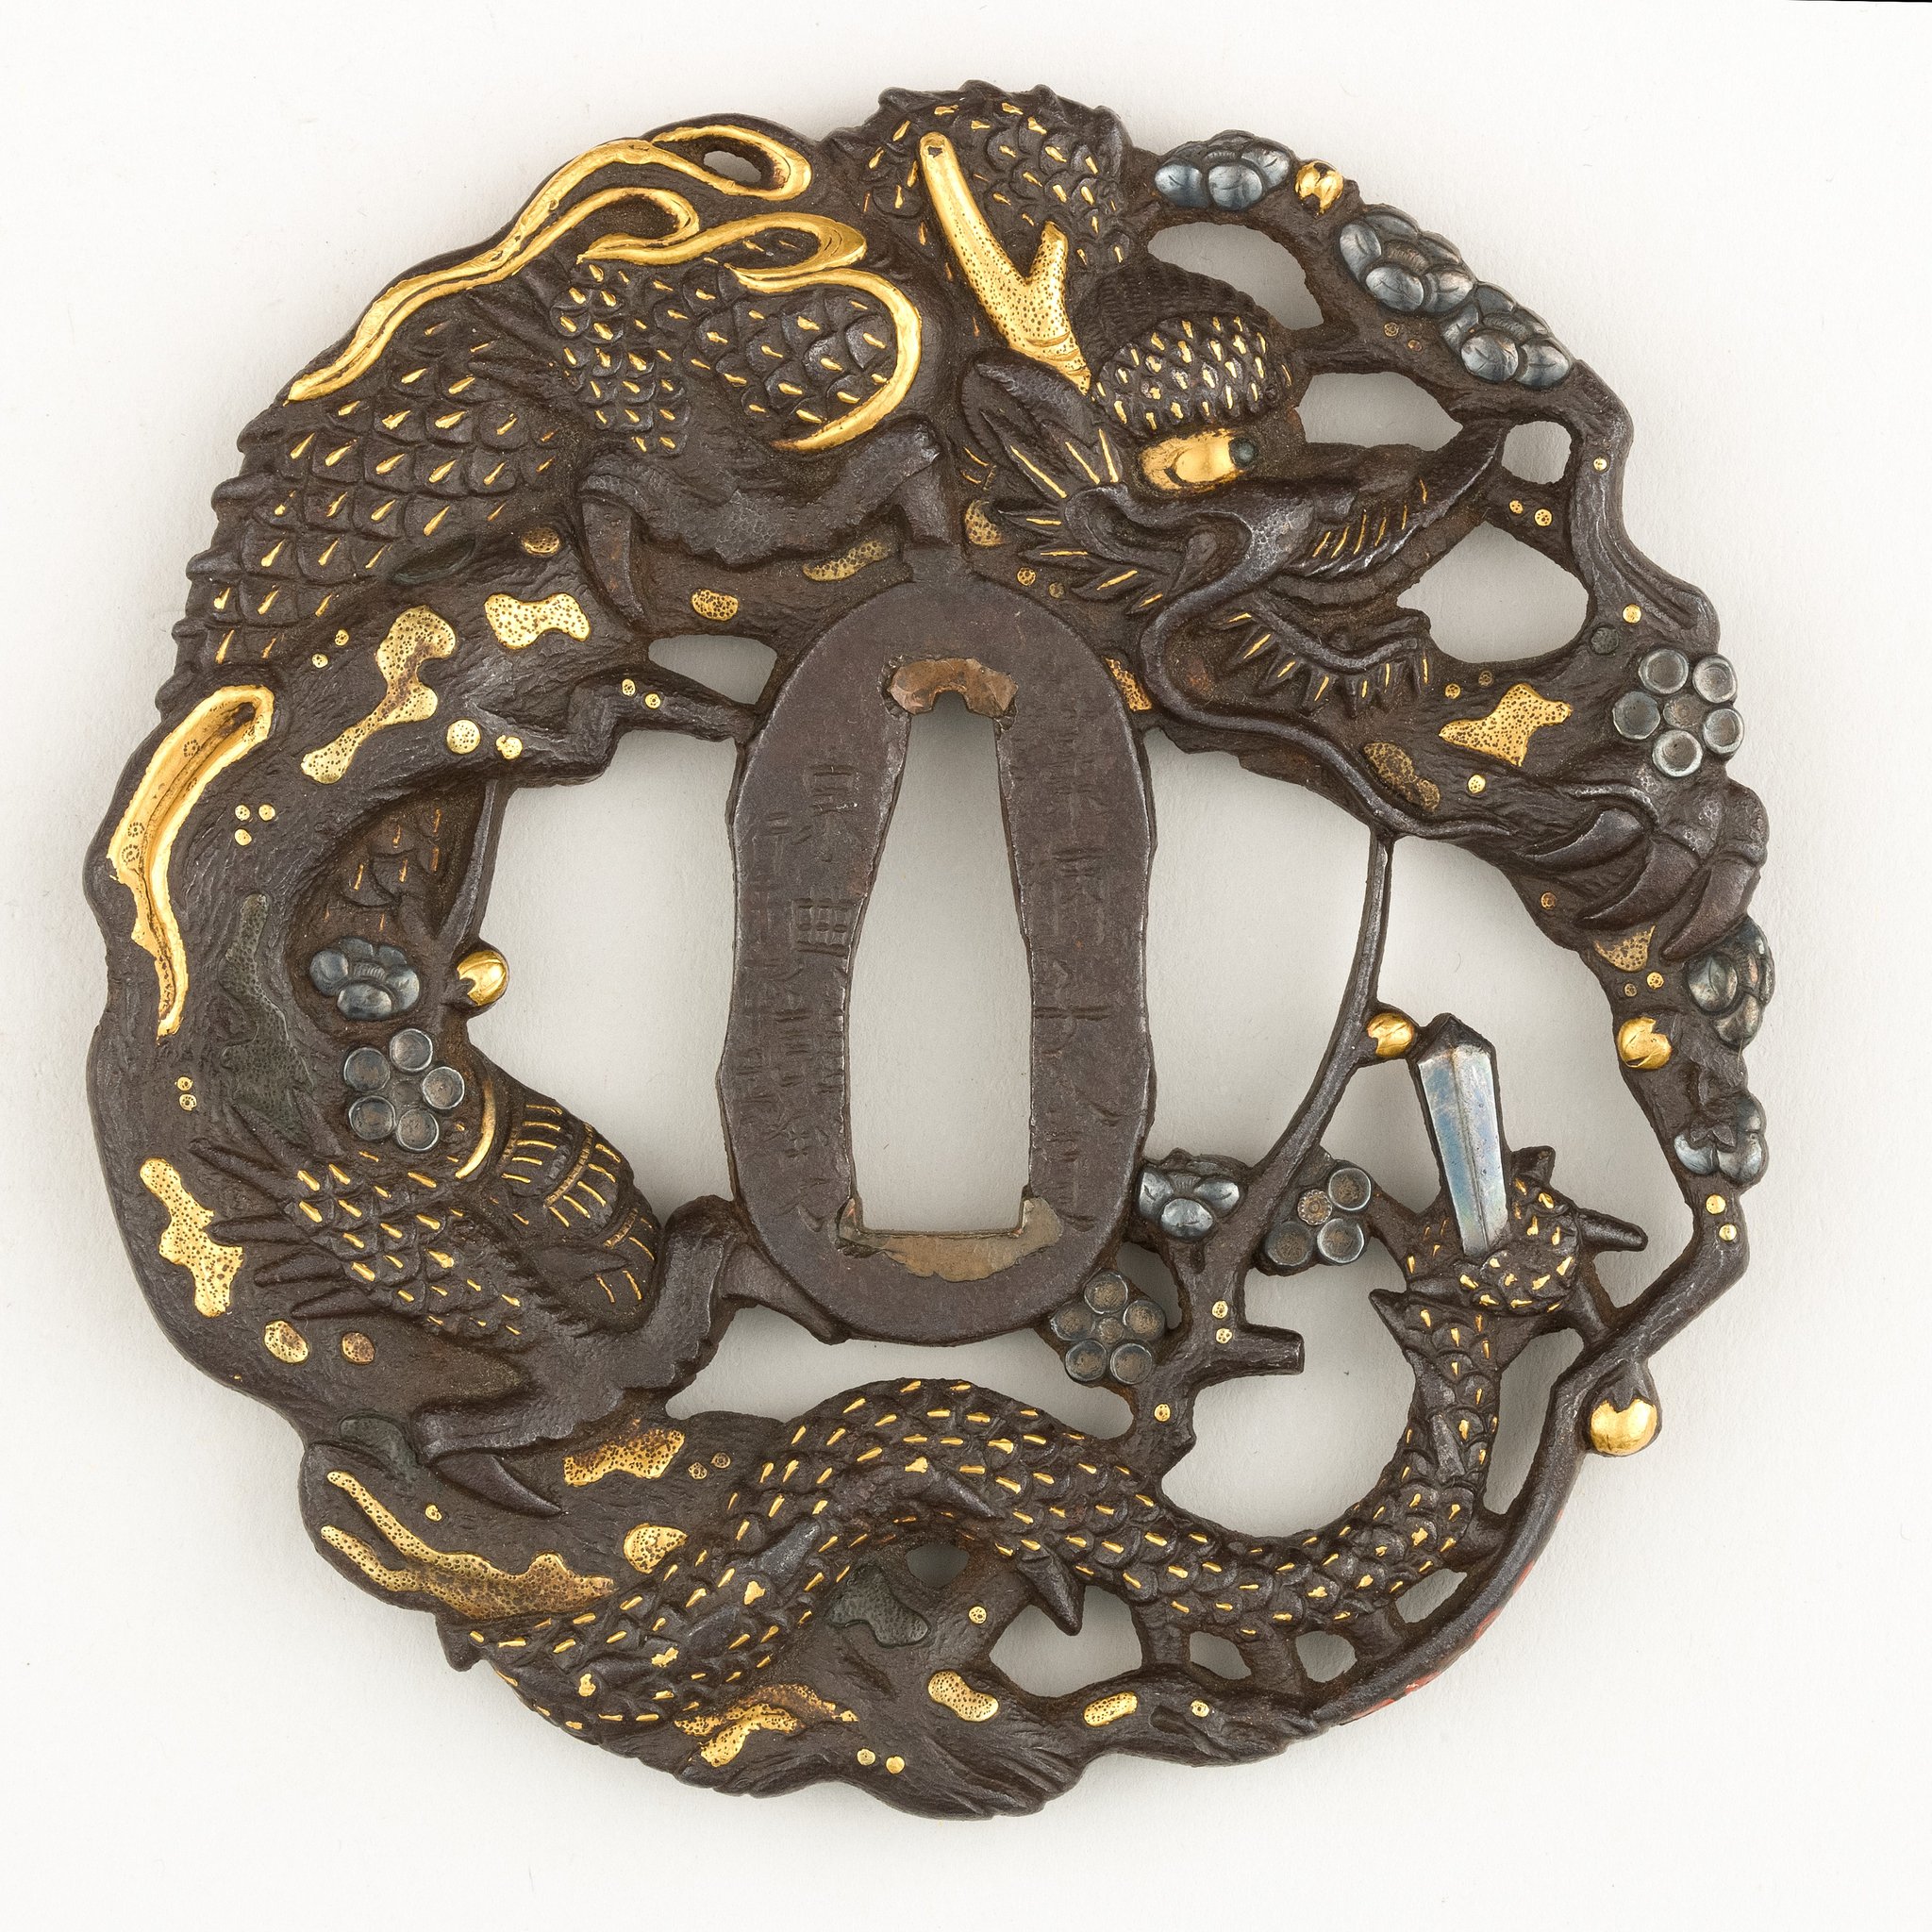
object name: sword guard tsuba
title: Sword Guard (Tsuba)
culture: japanese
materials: gold, silver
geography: japan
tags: dragons